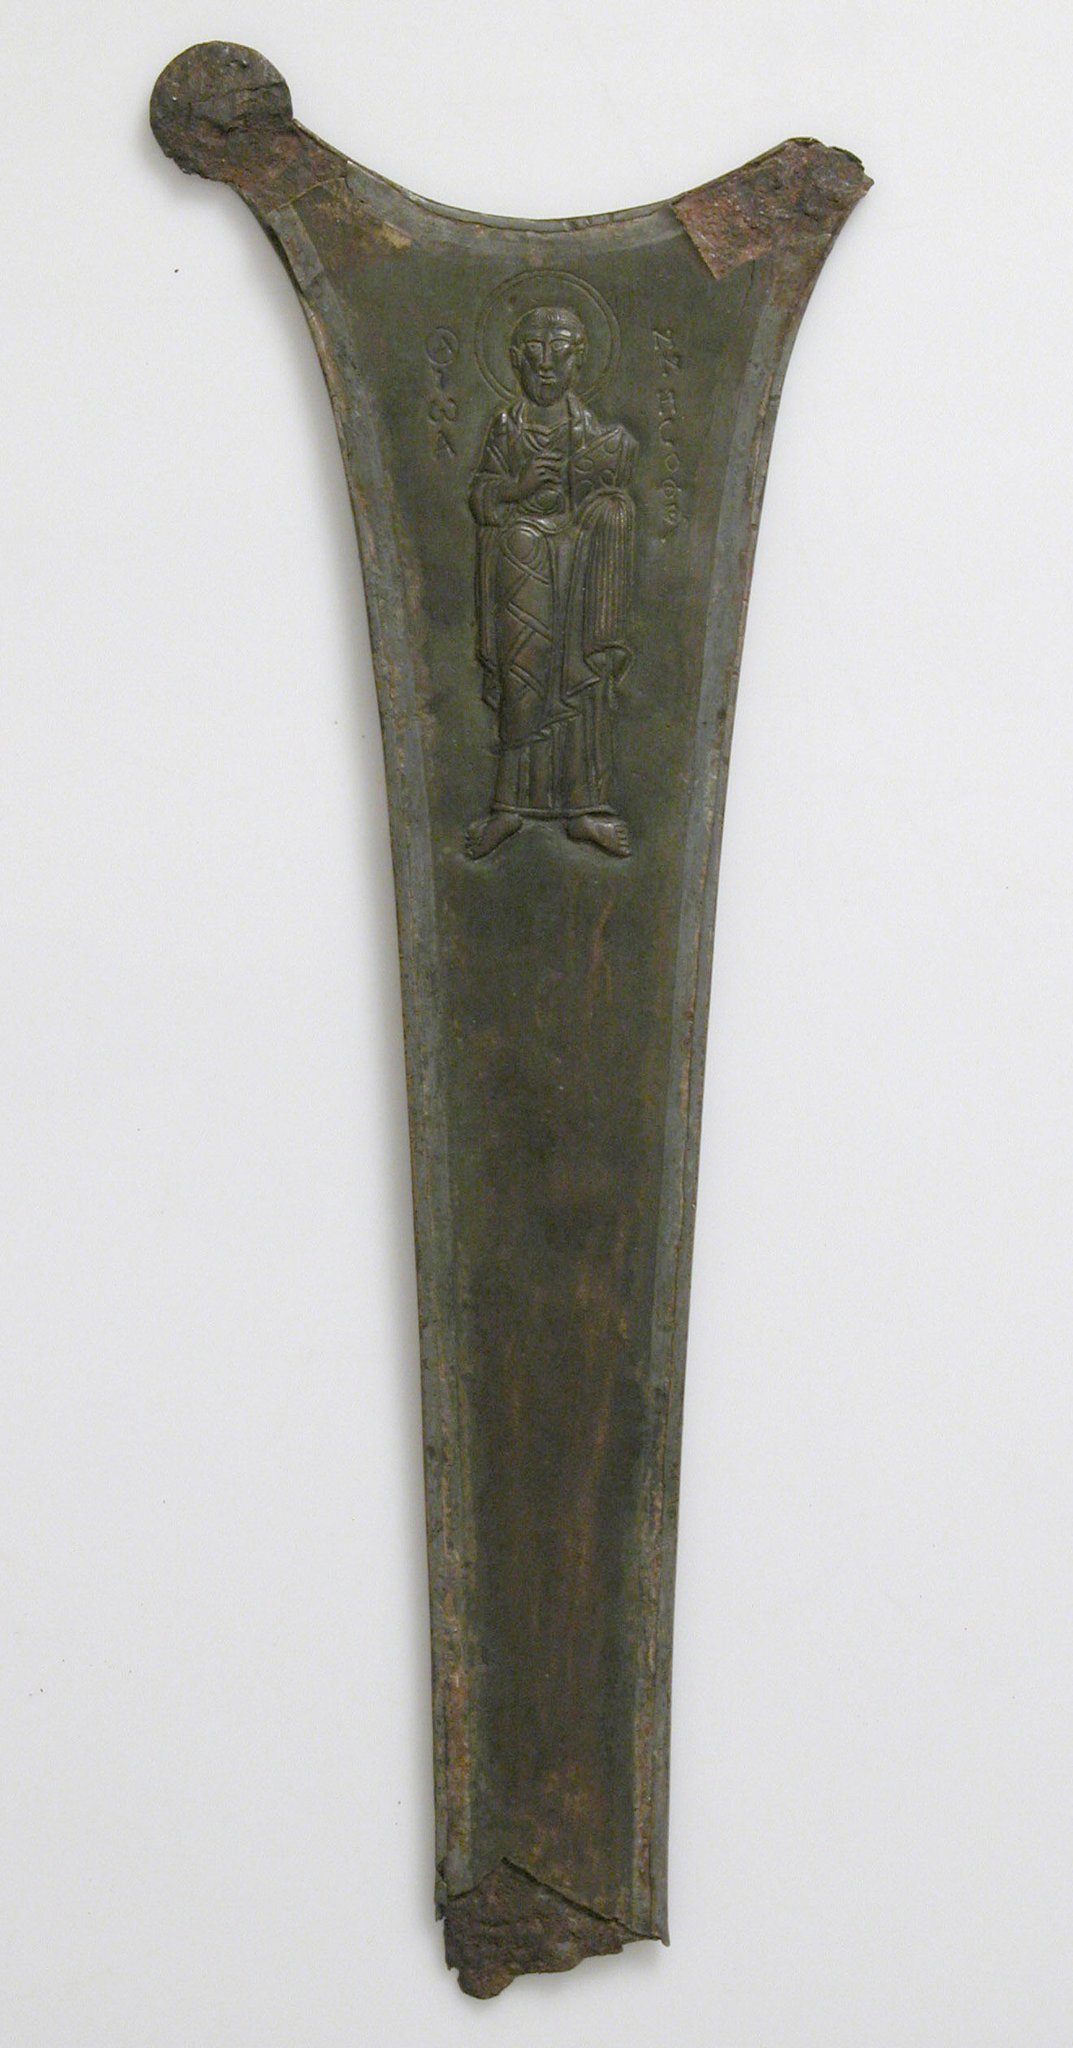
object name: cross fragment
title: Cross Fragment with Saint John the Theologian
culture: byzantine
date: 1001-1100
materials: copper alloy, iron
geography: probably constantinople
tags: cross